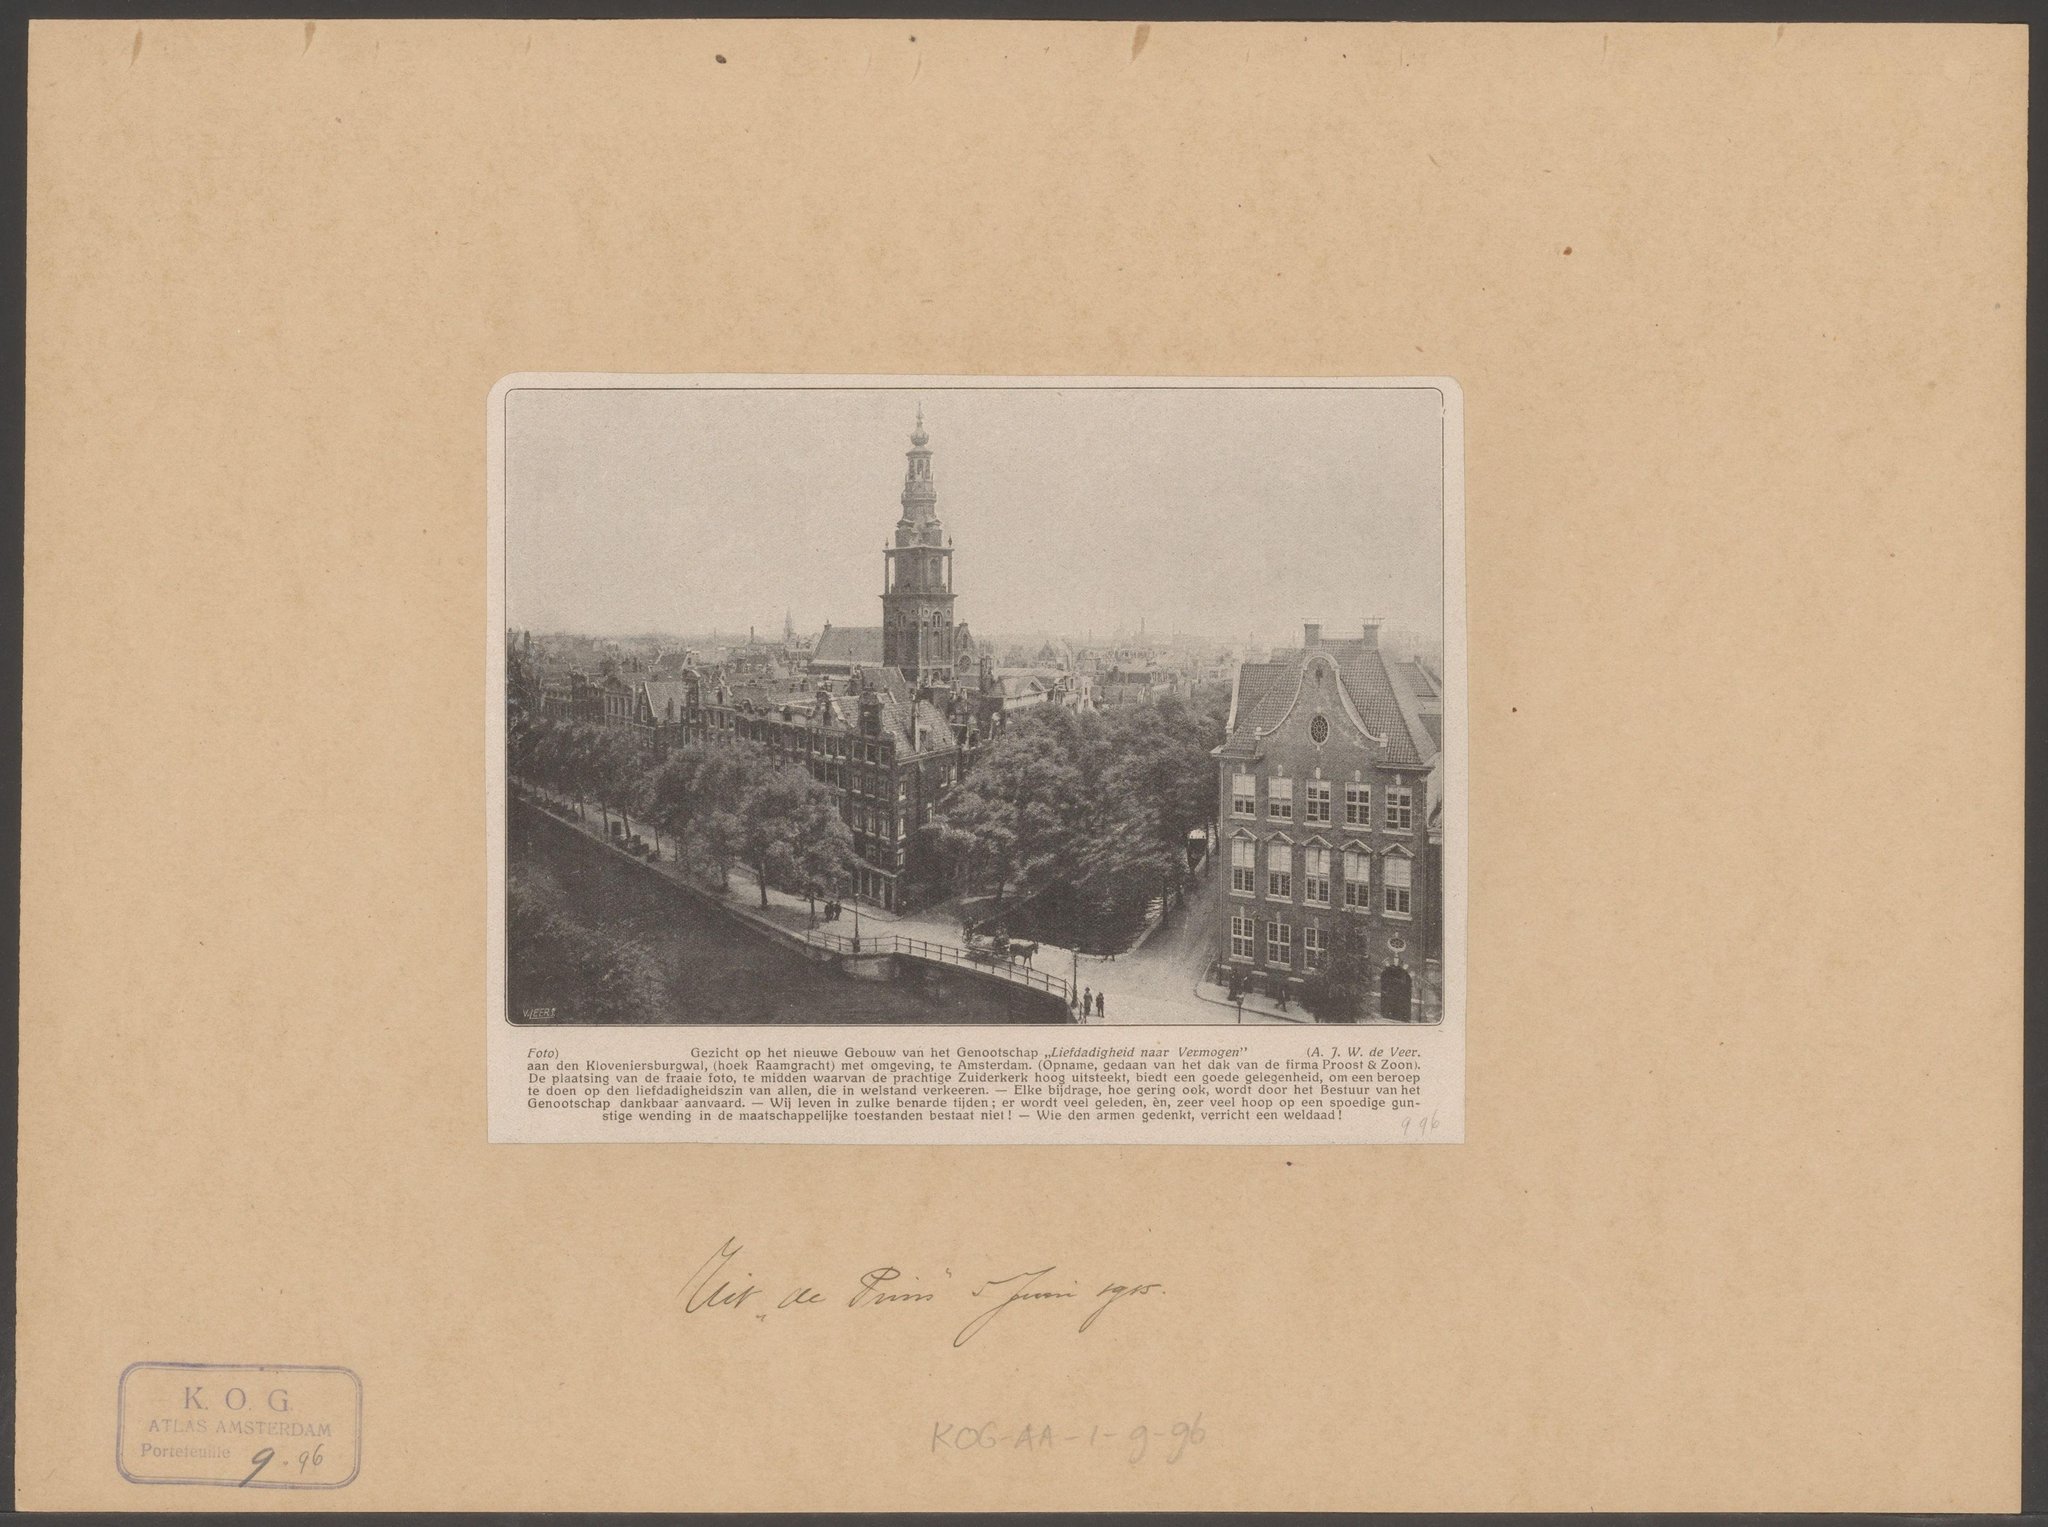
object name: photomechanical print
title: Gezicht op het gebouw van het genootschap Liefdadigheid naar Vermogen aan de Kloveniersburgwal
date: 1915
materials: paper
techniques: letterpress printing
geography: amsterdam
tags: tower, clock tower ~ monumental adornment, city-view in general; 'veduta', canal, street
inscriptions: collector's mark: ‘9.96’ Lugt 1641b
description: Onderwerpsrubriek binnen de Atlas Amsterdam: Kadijksplein, Karthuizerkerkhof, Kattegat, Kattenburg, Kapelsteeg O.Z., Enge Kerksteeg, Kerkstraat, Kinkerstraat, Kolk O.Z., Koningsplein, Kromboomsloot [Krom Boomssloot], Kostverlorenkade, Kwakersdwarspad, Kalverstraat, Keizersgracht (v.d. Brouwersgracht – Amstel), Klerensloot (Gedempte), Klimopstraat, Kloveniersburgwal, Kraansluis.